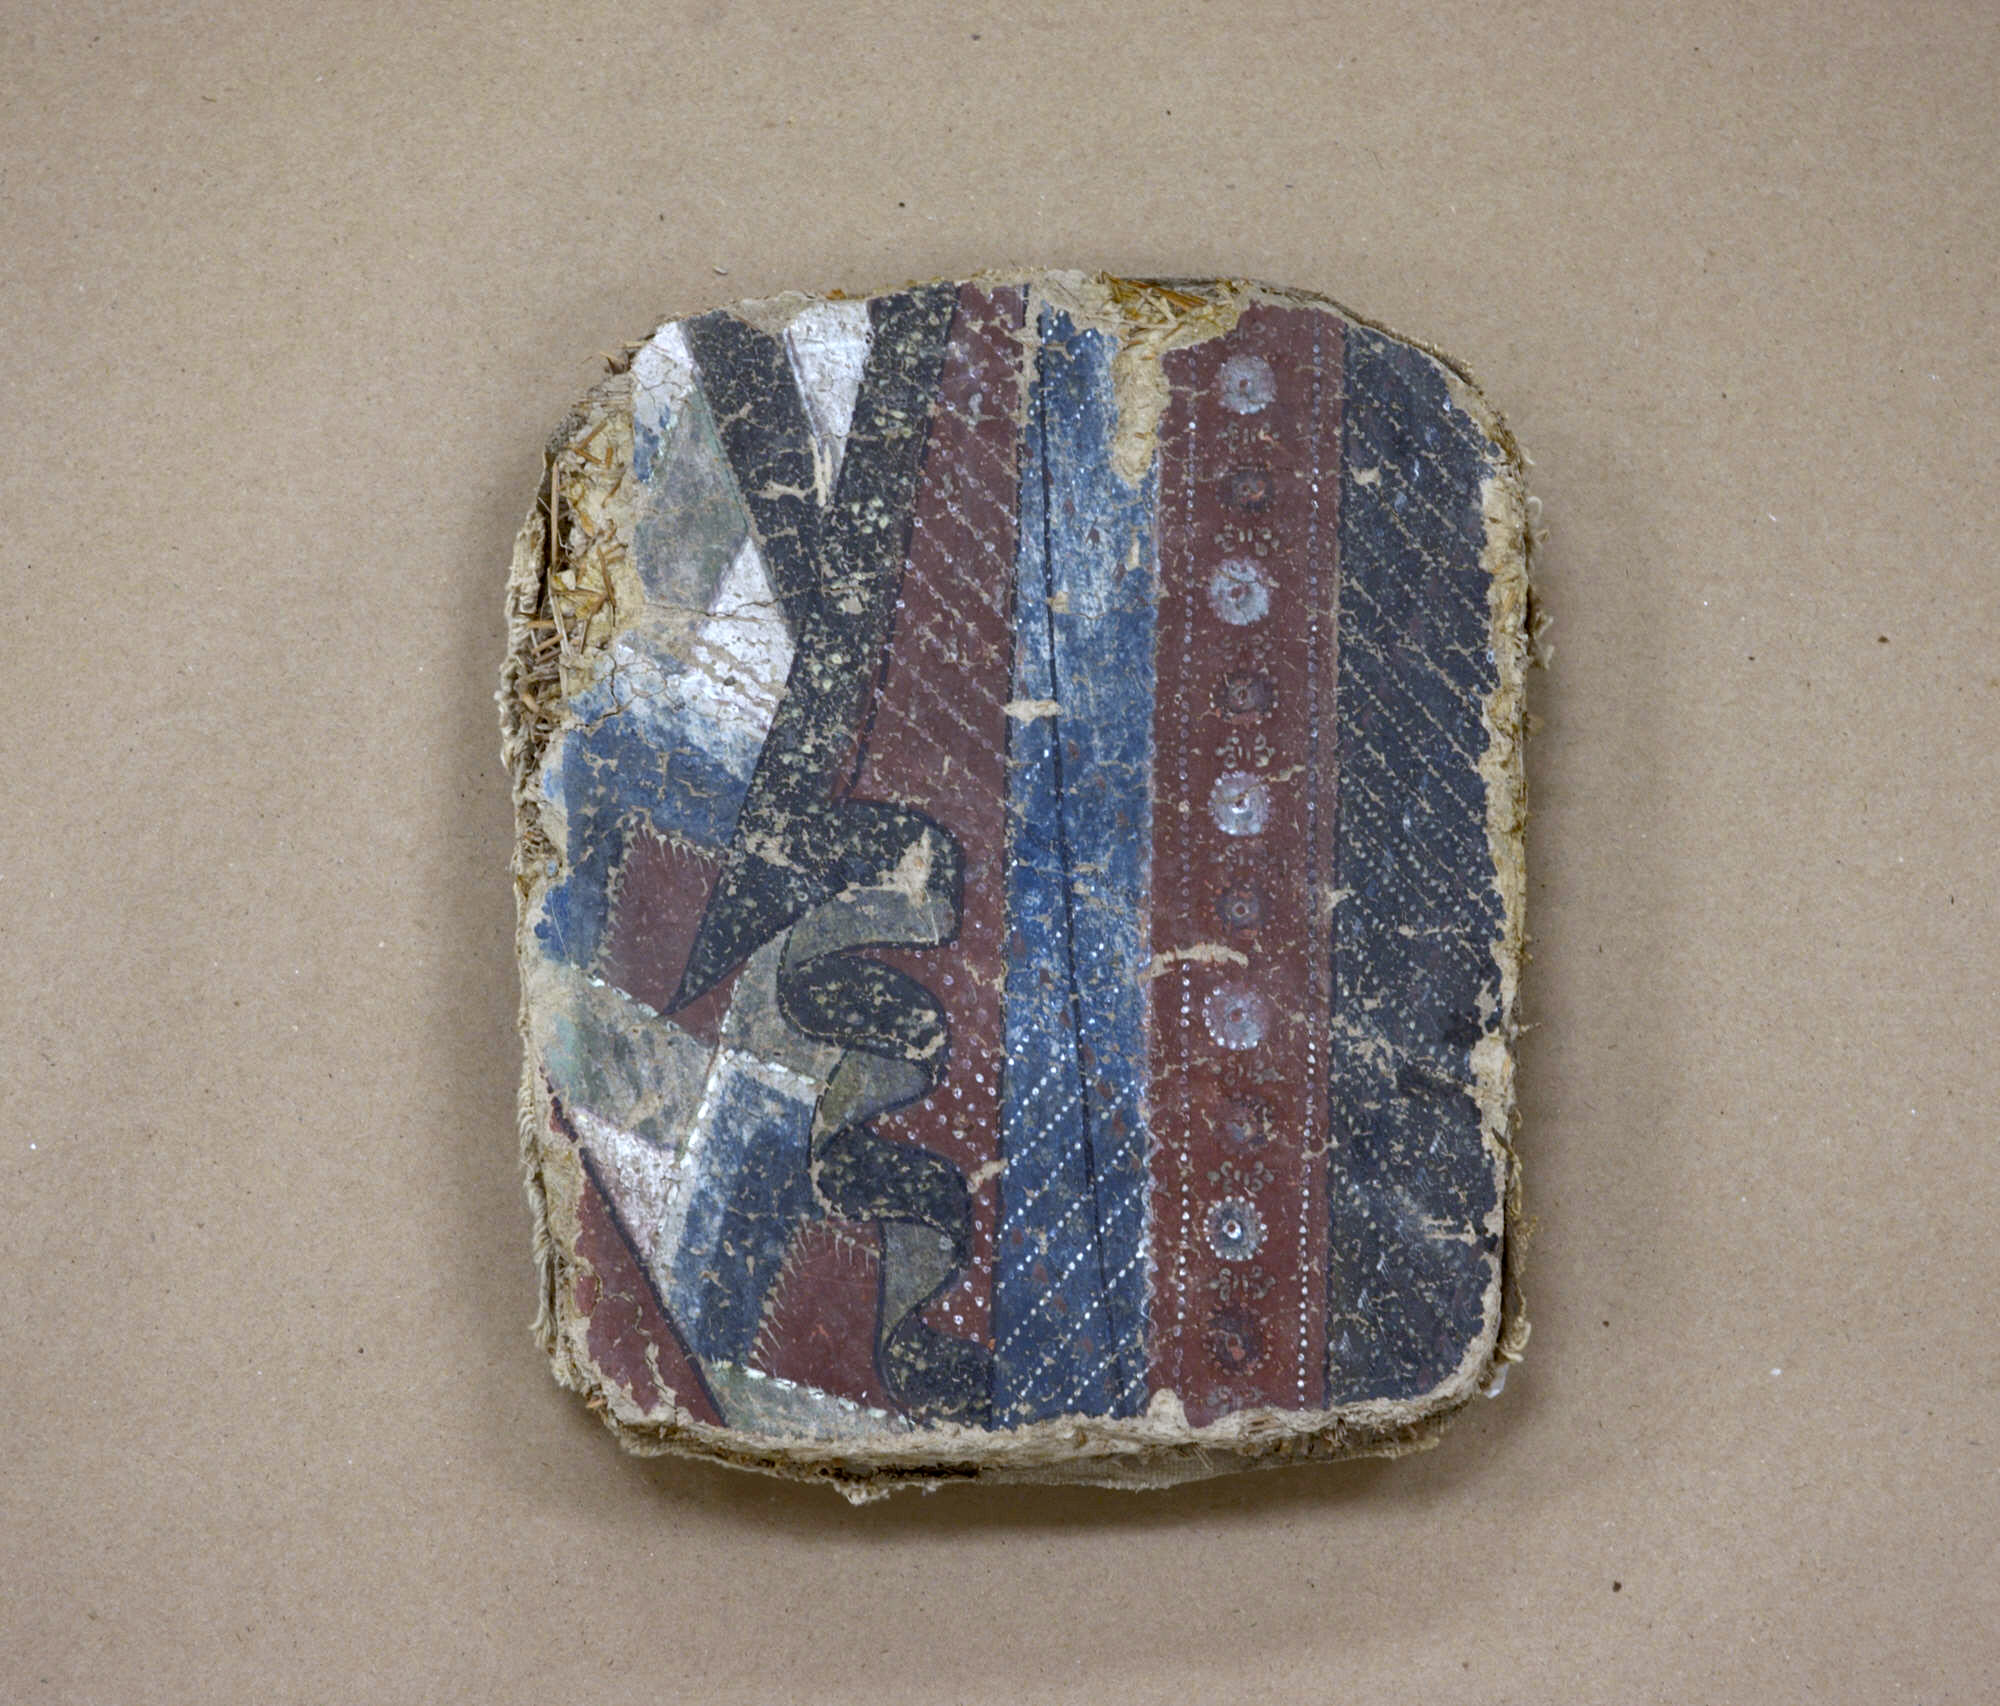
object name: wall painting fragment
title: Fragment of a Wall Painting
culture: central asian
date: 701-800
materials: pigment, fiber